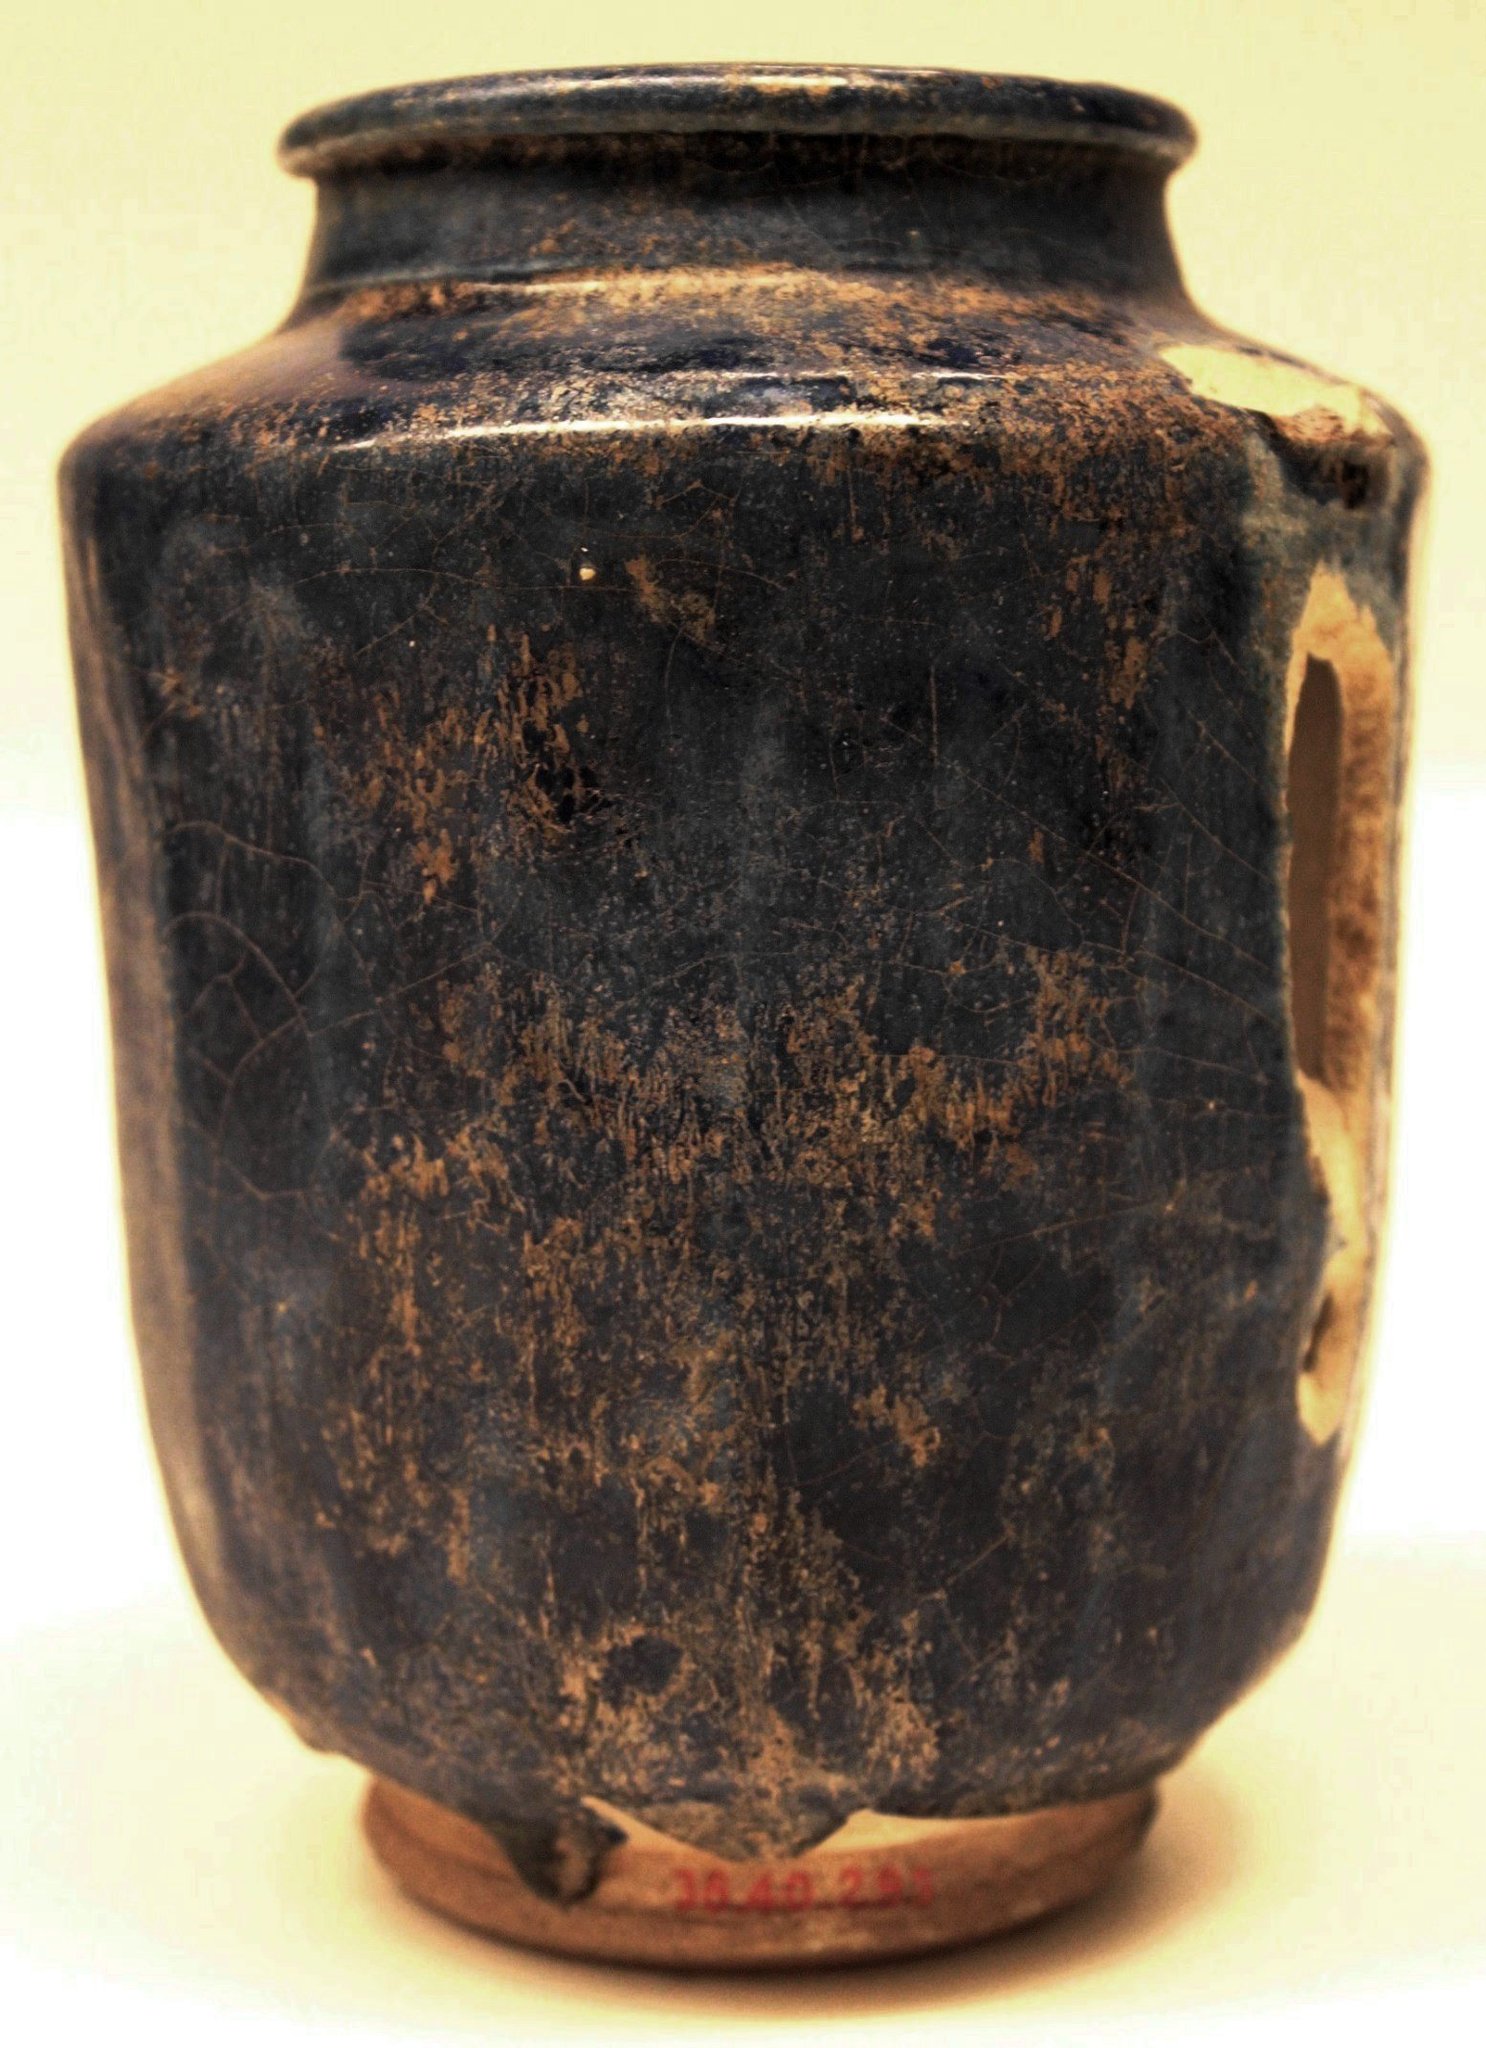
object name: jar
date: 1001-1200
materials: earthenware, glaze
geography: iran